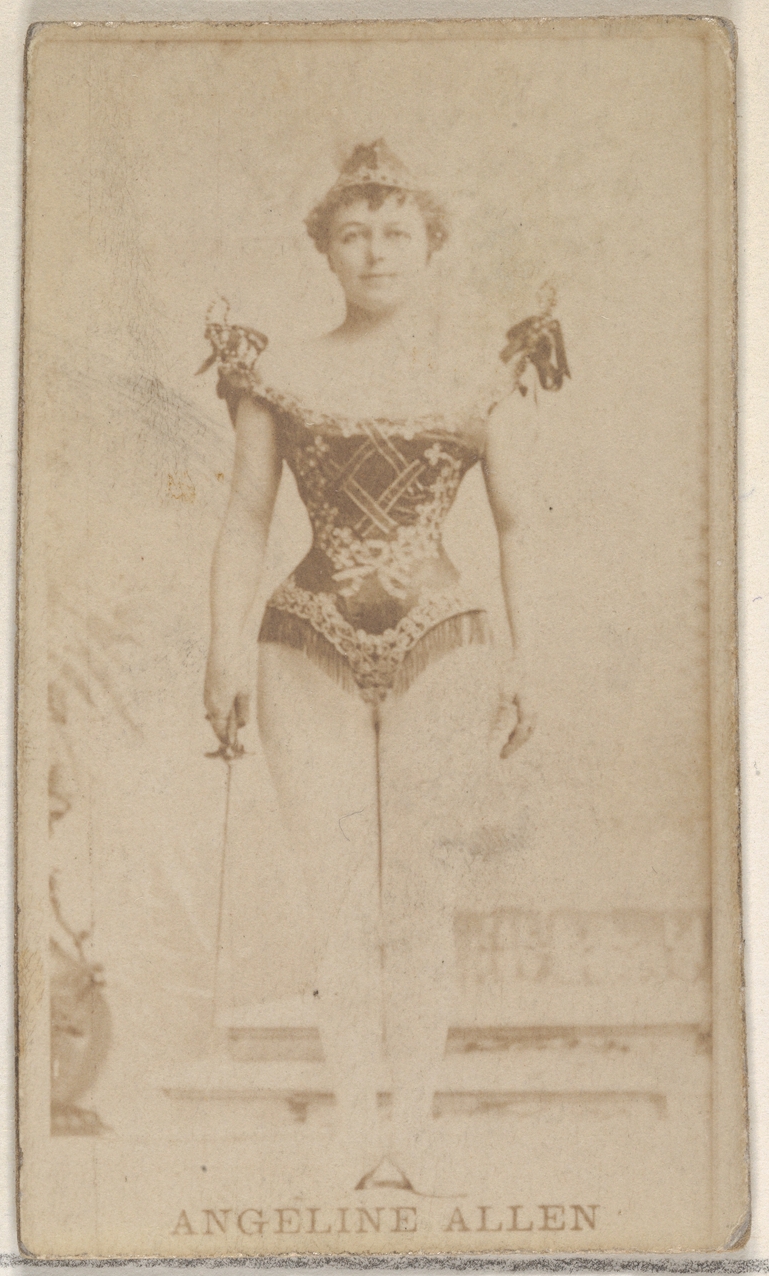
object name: photograph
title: Angeline Allen, from the Actors and Actresses series (N45, Type 8) for Virginia Brights Cigarettes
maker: allen & ginter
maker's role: publisher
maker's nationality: american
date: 1888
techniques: albumen silver print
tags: portraits,women,actresses